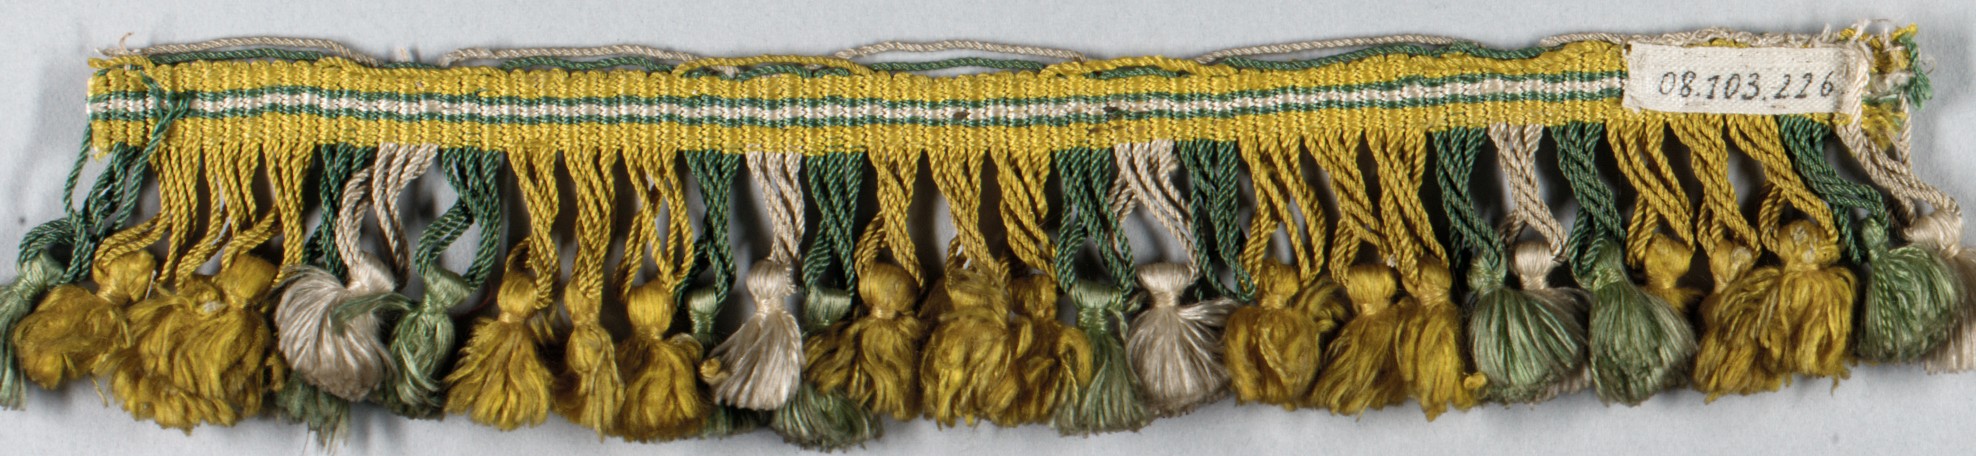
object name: fringe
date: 1801-1900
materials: silk